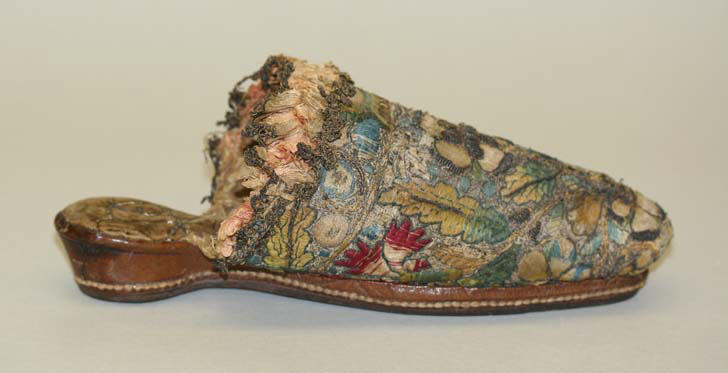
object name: mule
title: Mules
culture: british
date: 1601-1625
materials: leather, linen, silk